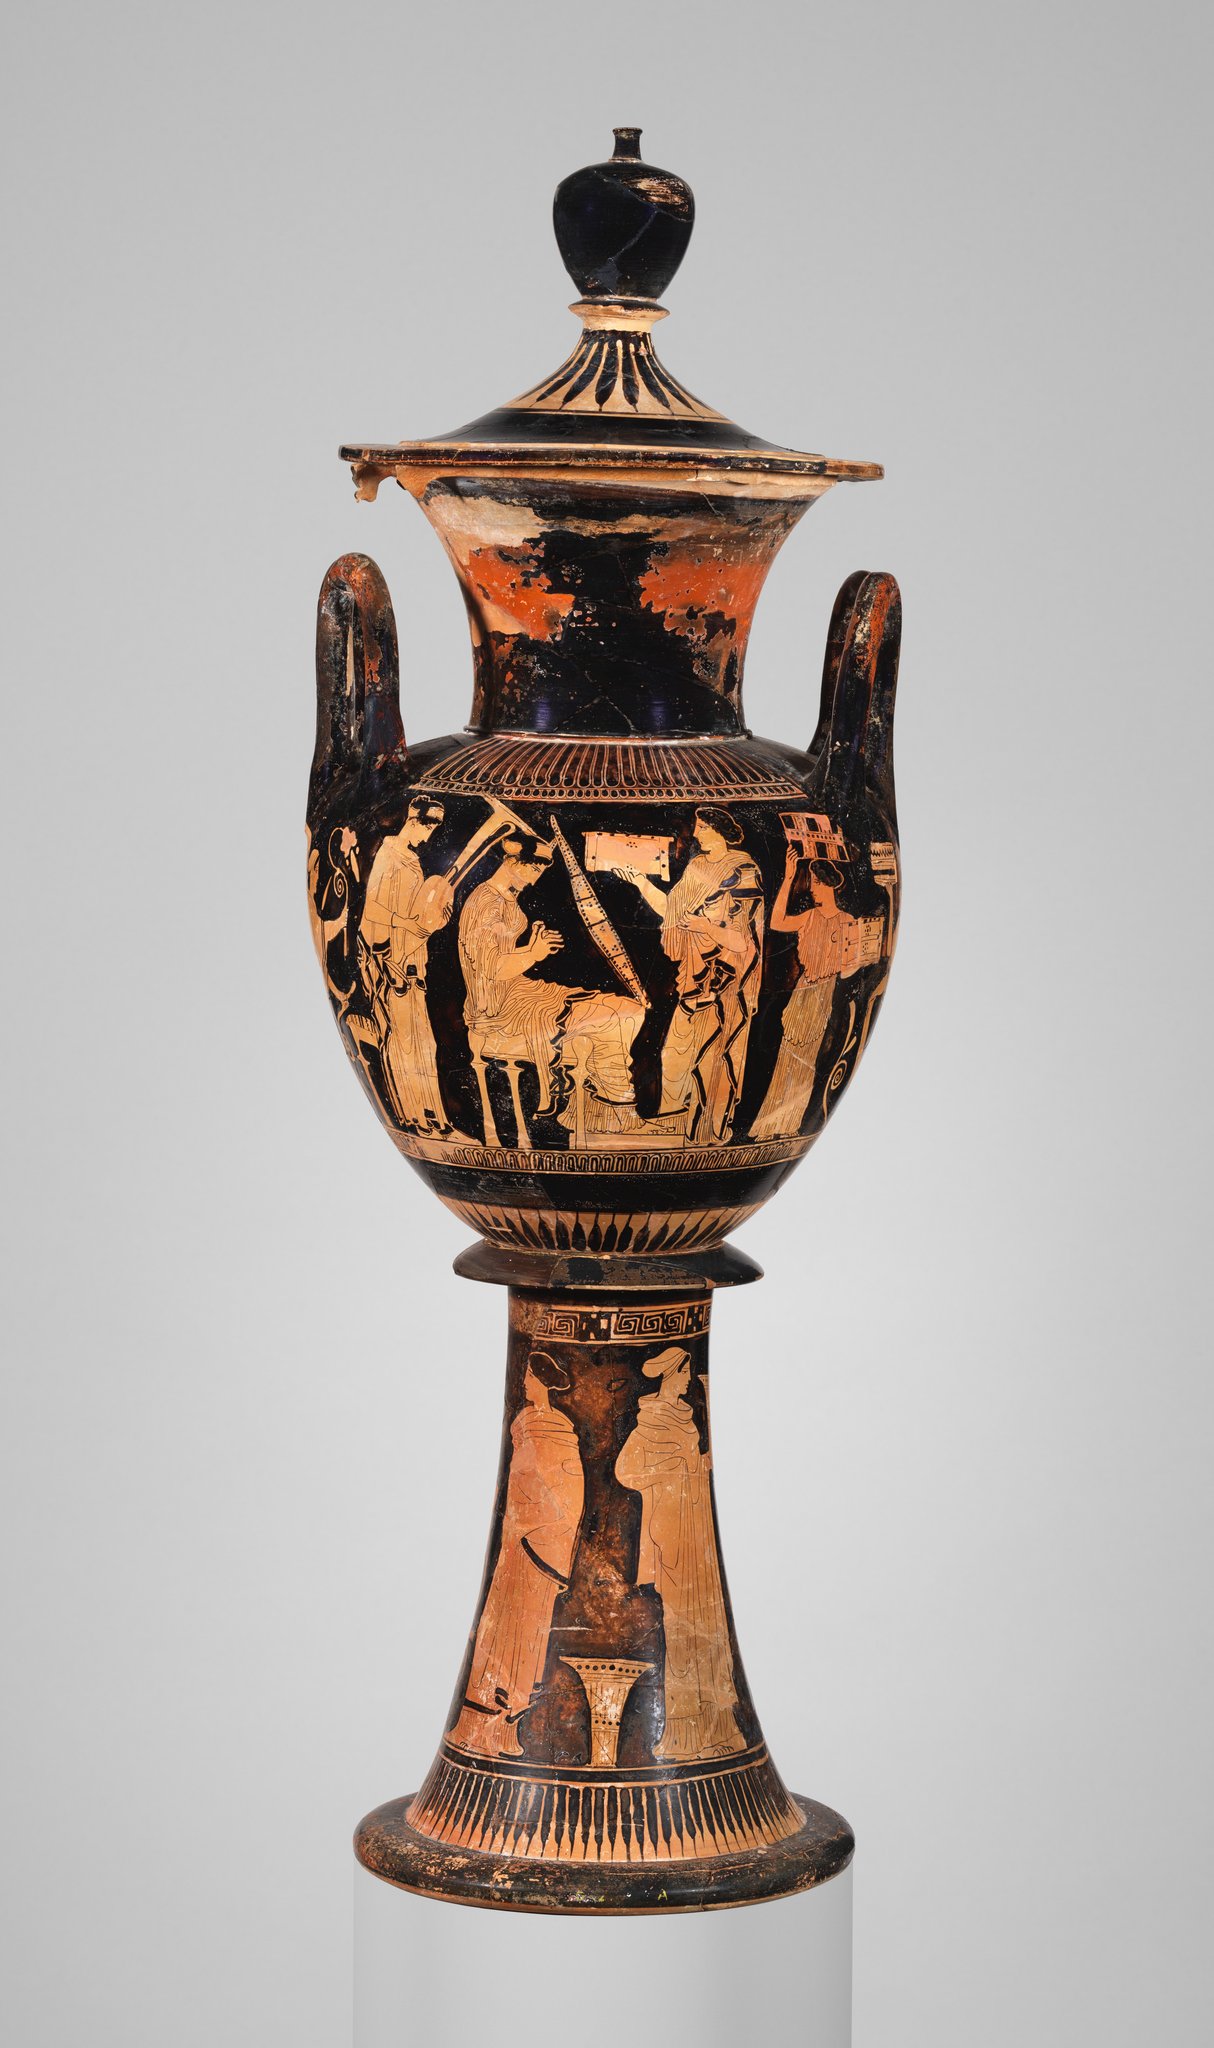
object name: lebes gamikos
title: Terracotta lebes gamikos (round-bottomed bowl with handles and stand used in weddings)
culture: greek, attic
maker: washing painter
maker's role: artist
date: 430-420 BCE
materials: terracotta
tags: women